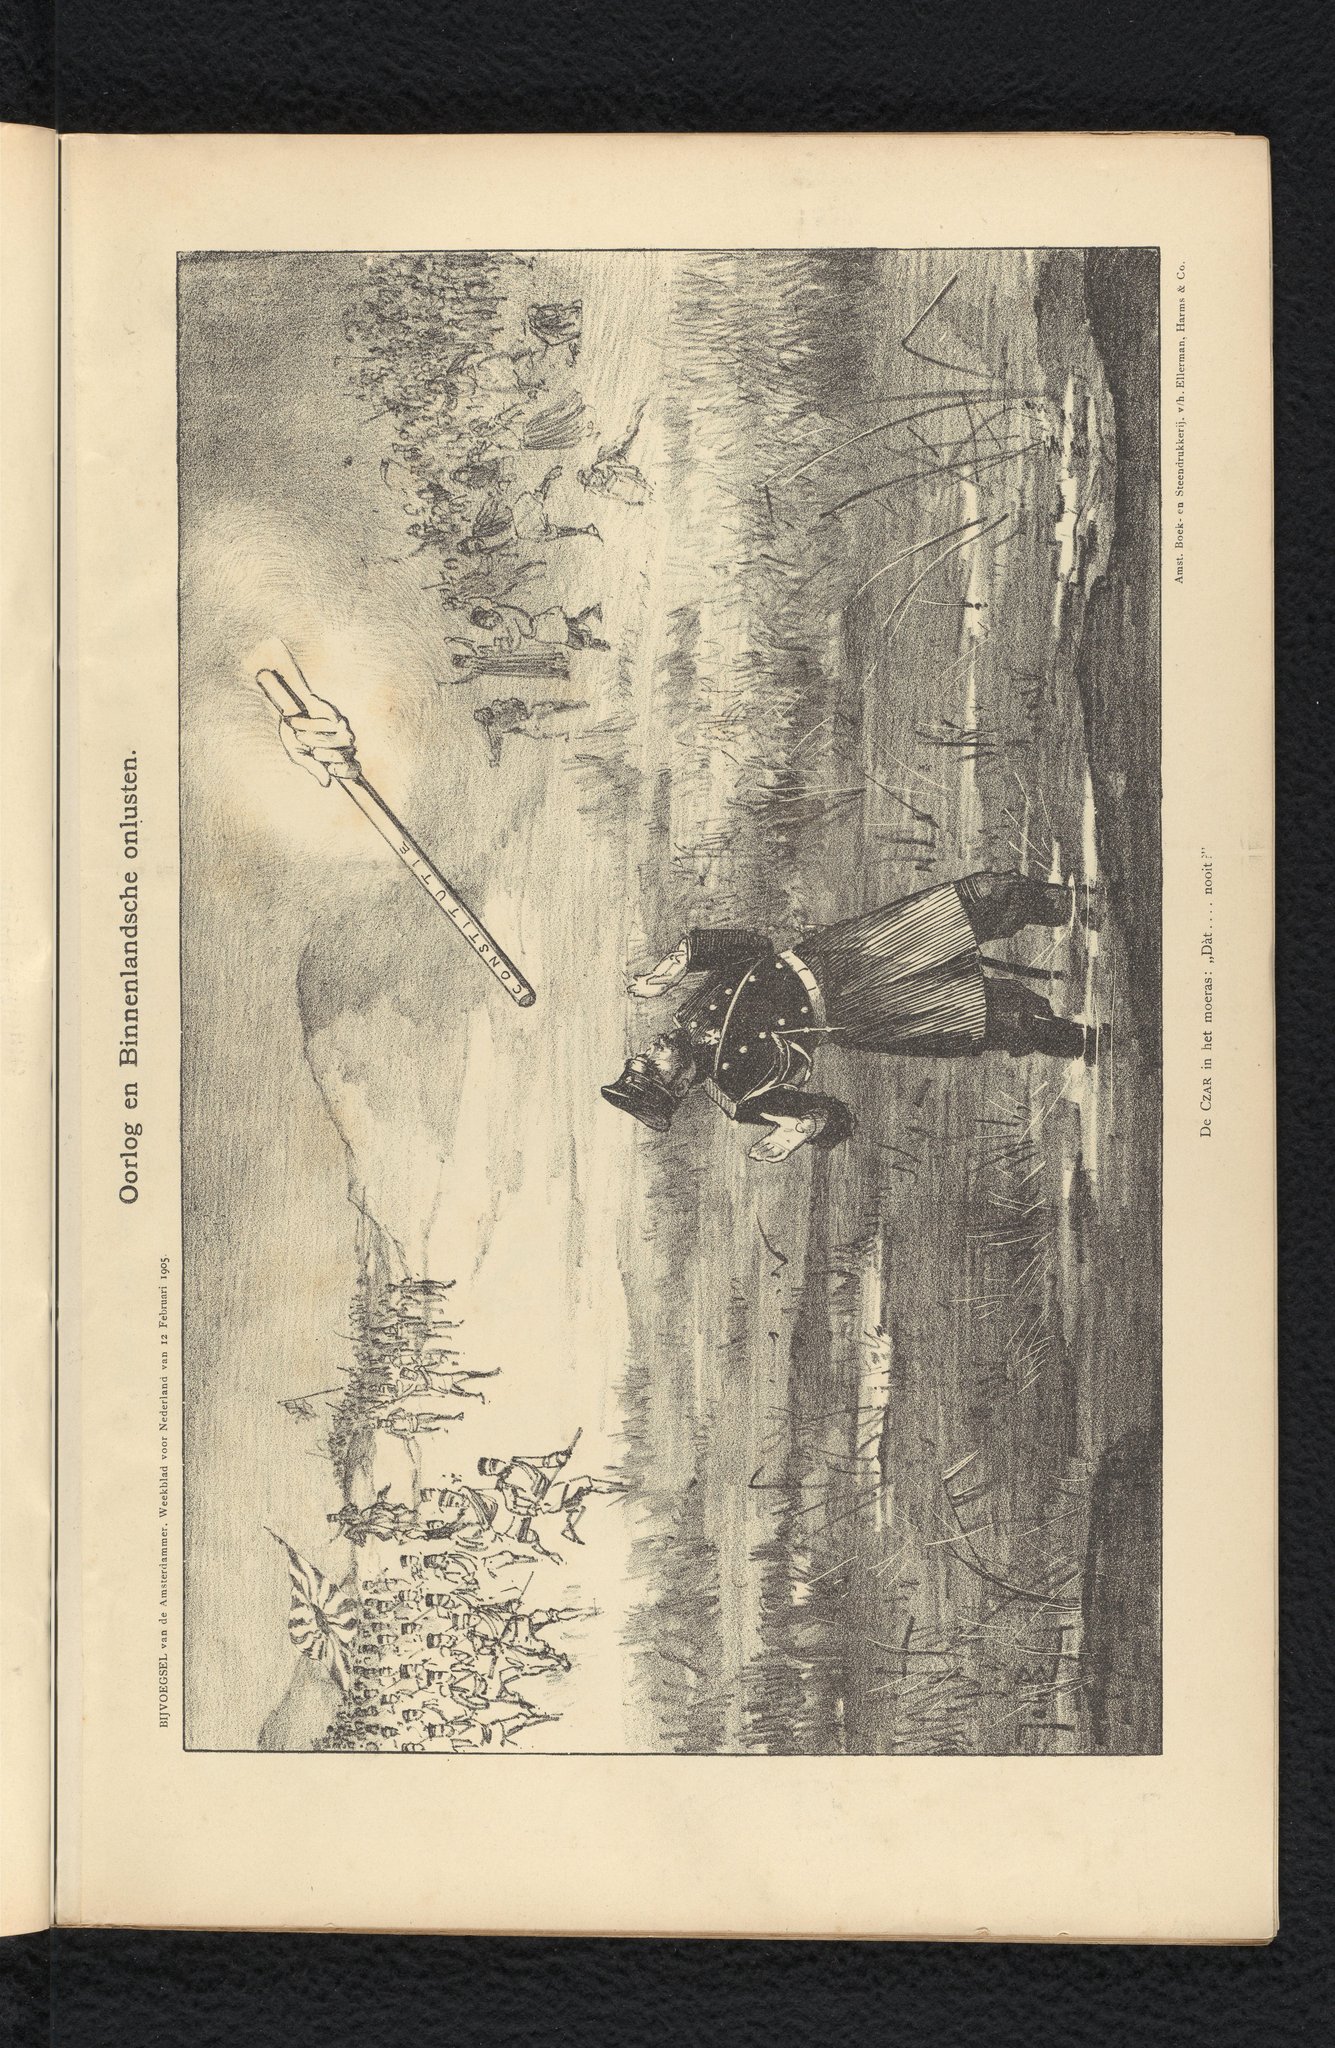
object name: cartoon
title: Oorlog en Binnenlandsche onlusten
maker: johan braakensiek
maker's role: draughtsman, print maker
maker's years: 1858-1940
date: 1905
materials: paper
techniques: lithograph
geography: netherlands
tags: swamp, inland marsh, fens, political caricatures and satires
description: De Russische tsaar Nicolaas II tot aan zijn knieën in het moeras tussen links, het aanstormende Japanse leger en rechts, opstand onder de Russische bevolking. Hij weigert de door een hand uit de lucht aangereikte oplossing: een constitutie.